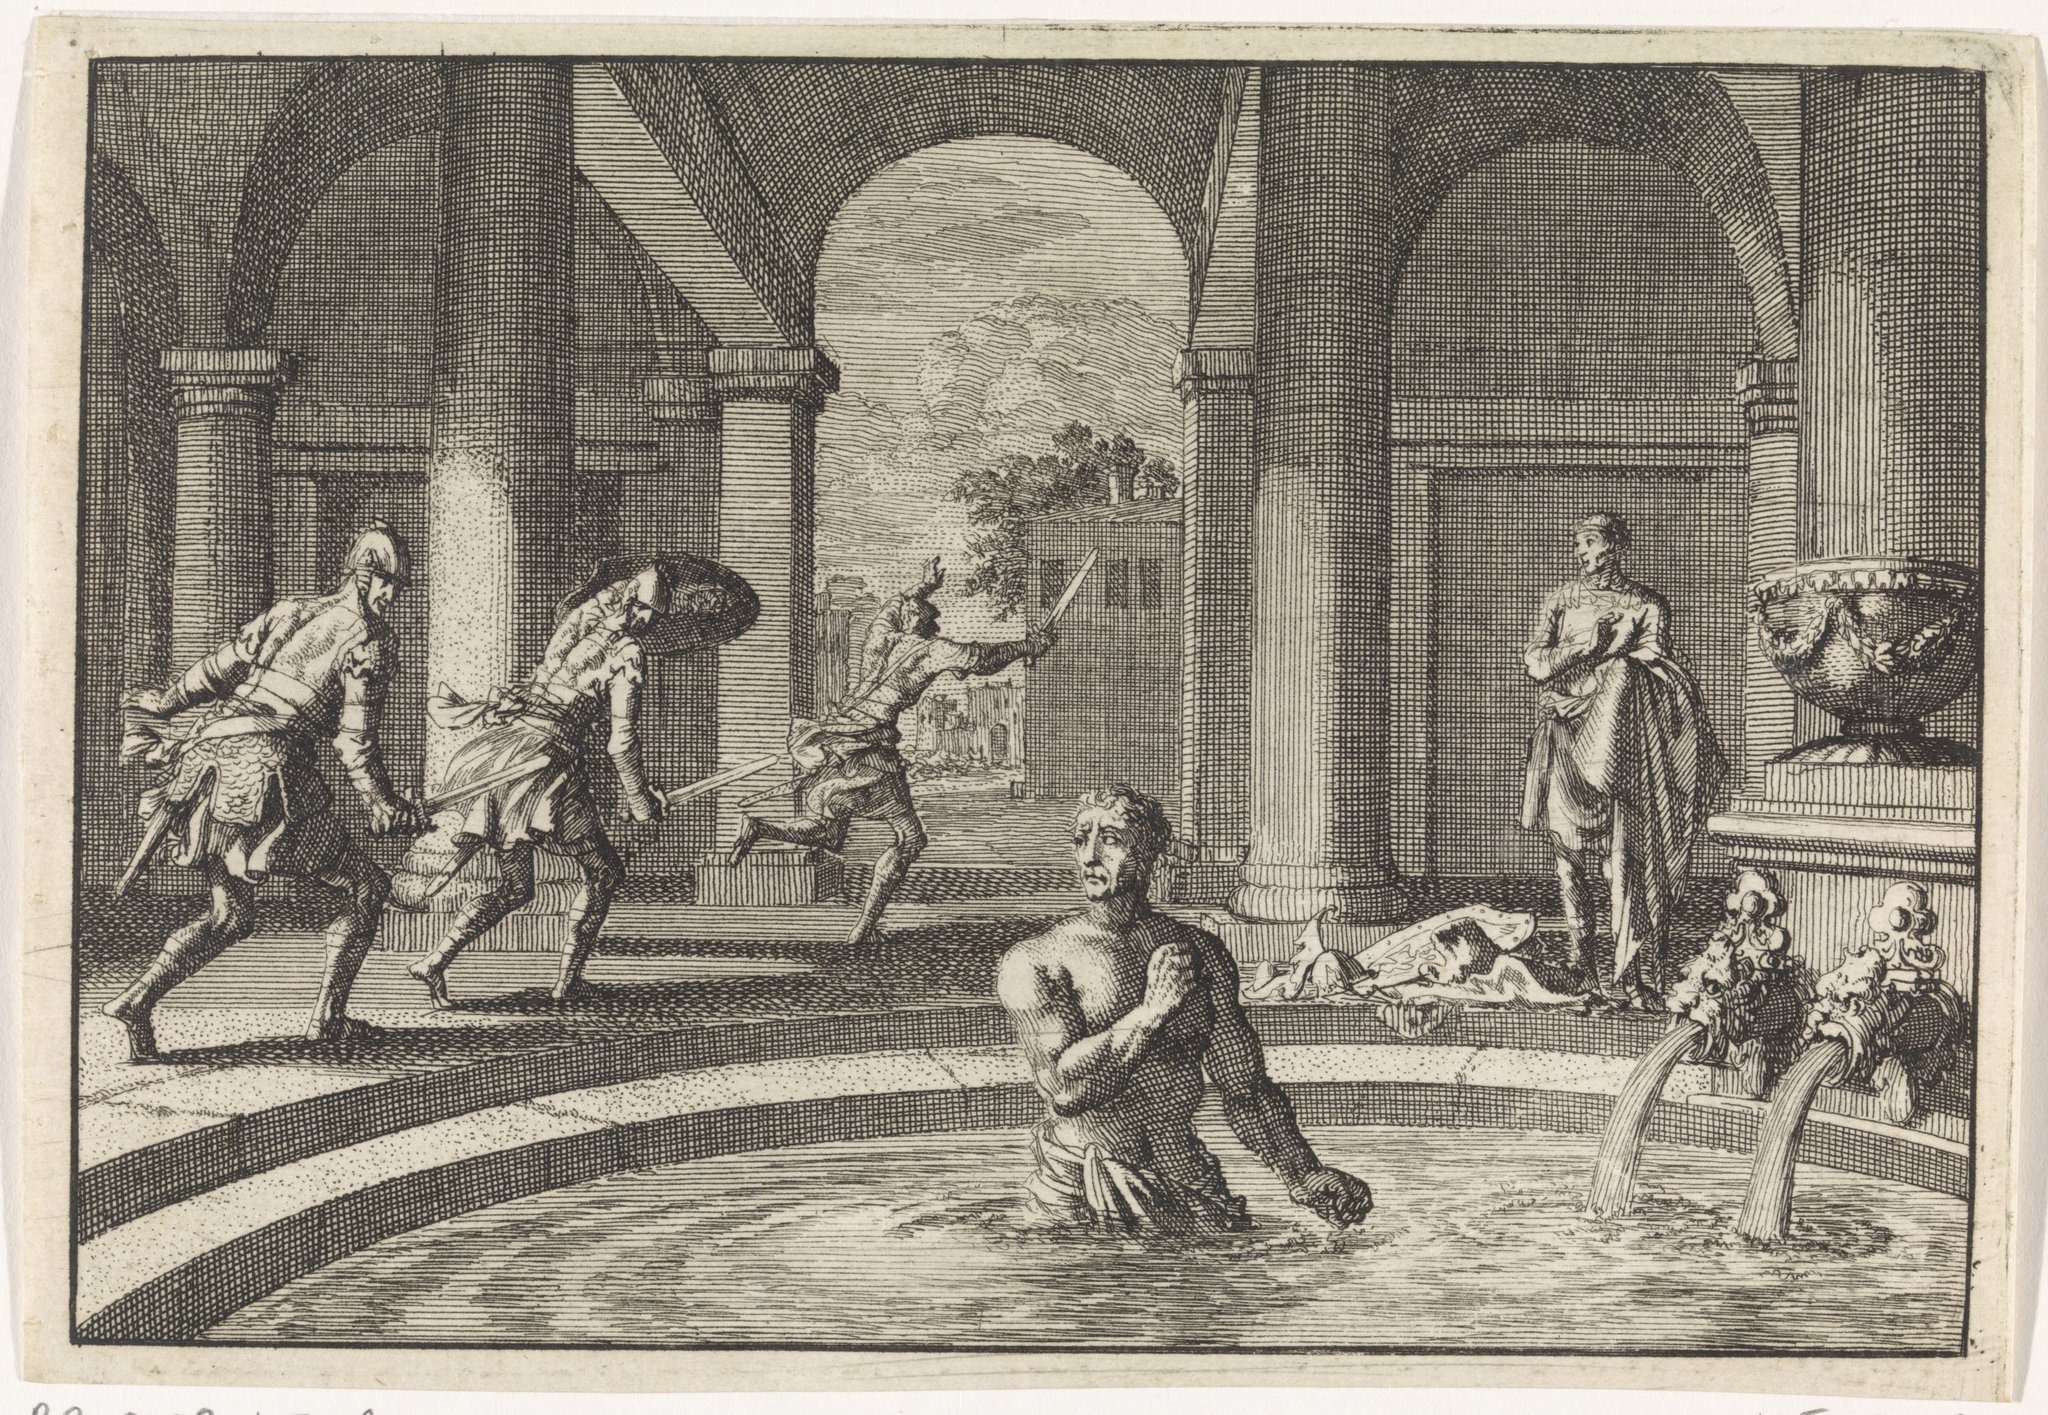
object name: print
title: Gewapende vijanden slaan op de vlucht wanneer zij Herodes na zijn overwinning op het leger van Antigonus in bad zien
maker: jan luyken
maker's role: draughtsman, print maker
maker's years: 1649-1712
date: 1704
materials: paper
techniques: etching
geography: amsterdam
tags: taking a bath, flight, running away; pursuing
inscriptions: collector's mark: Lugt 2228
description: Prent ook gebruikt als boekillustratie in: Josephus, Flavius. Alle de Werken, 2 delen. Amsterdam: Pieter Mortier, 1704, dl. 2, p. 532.